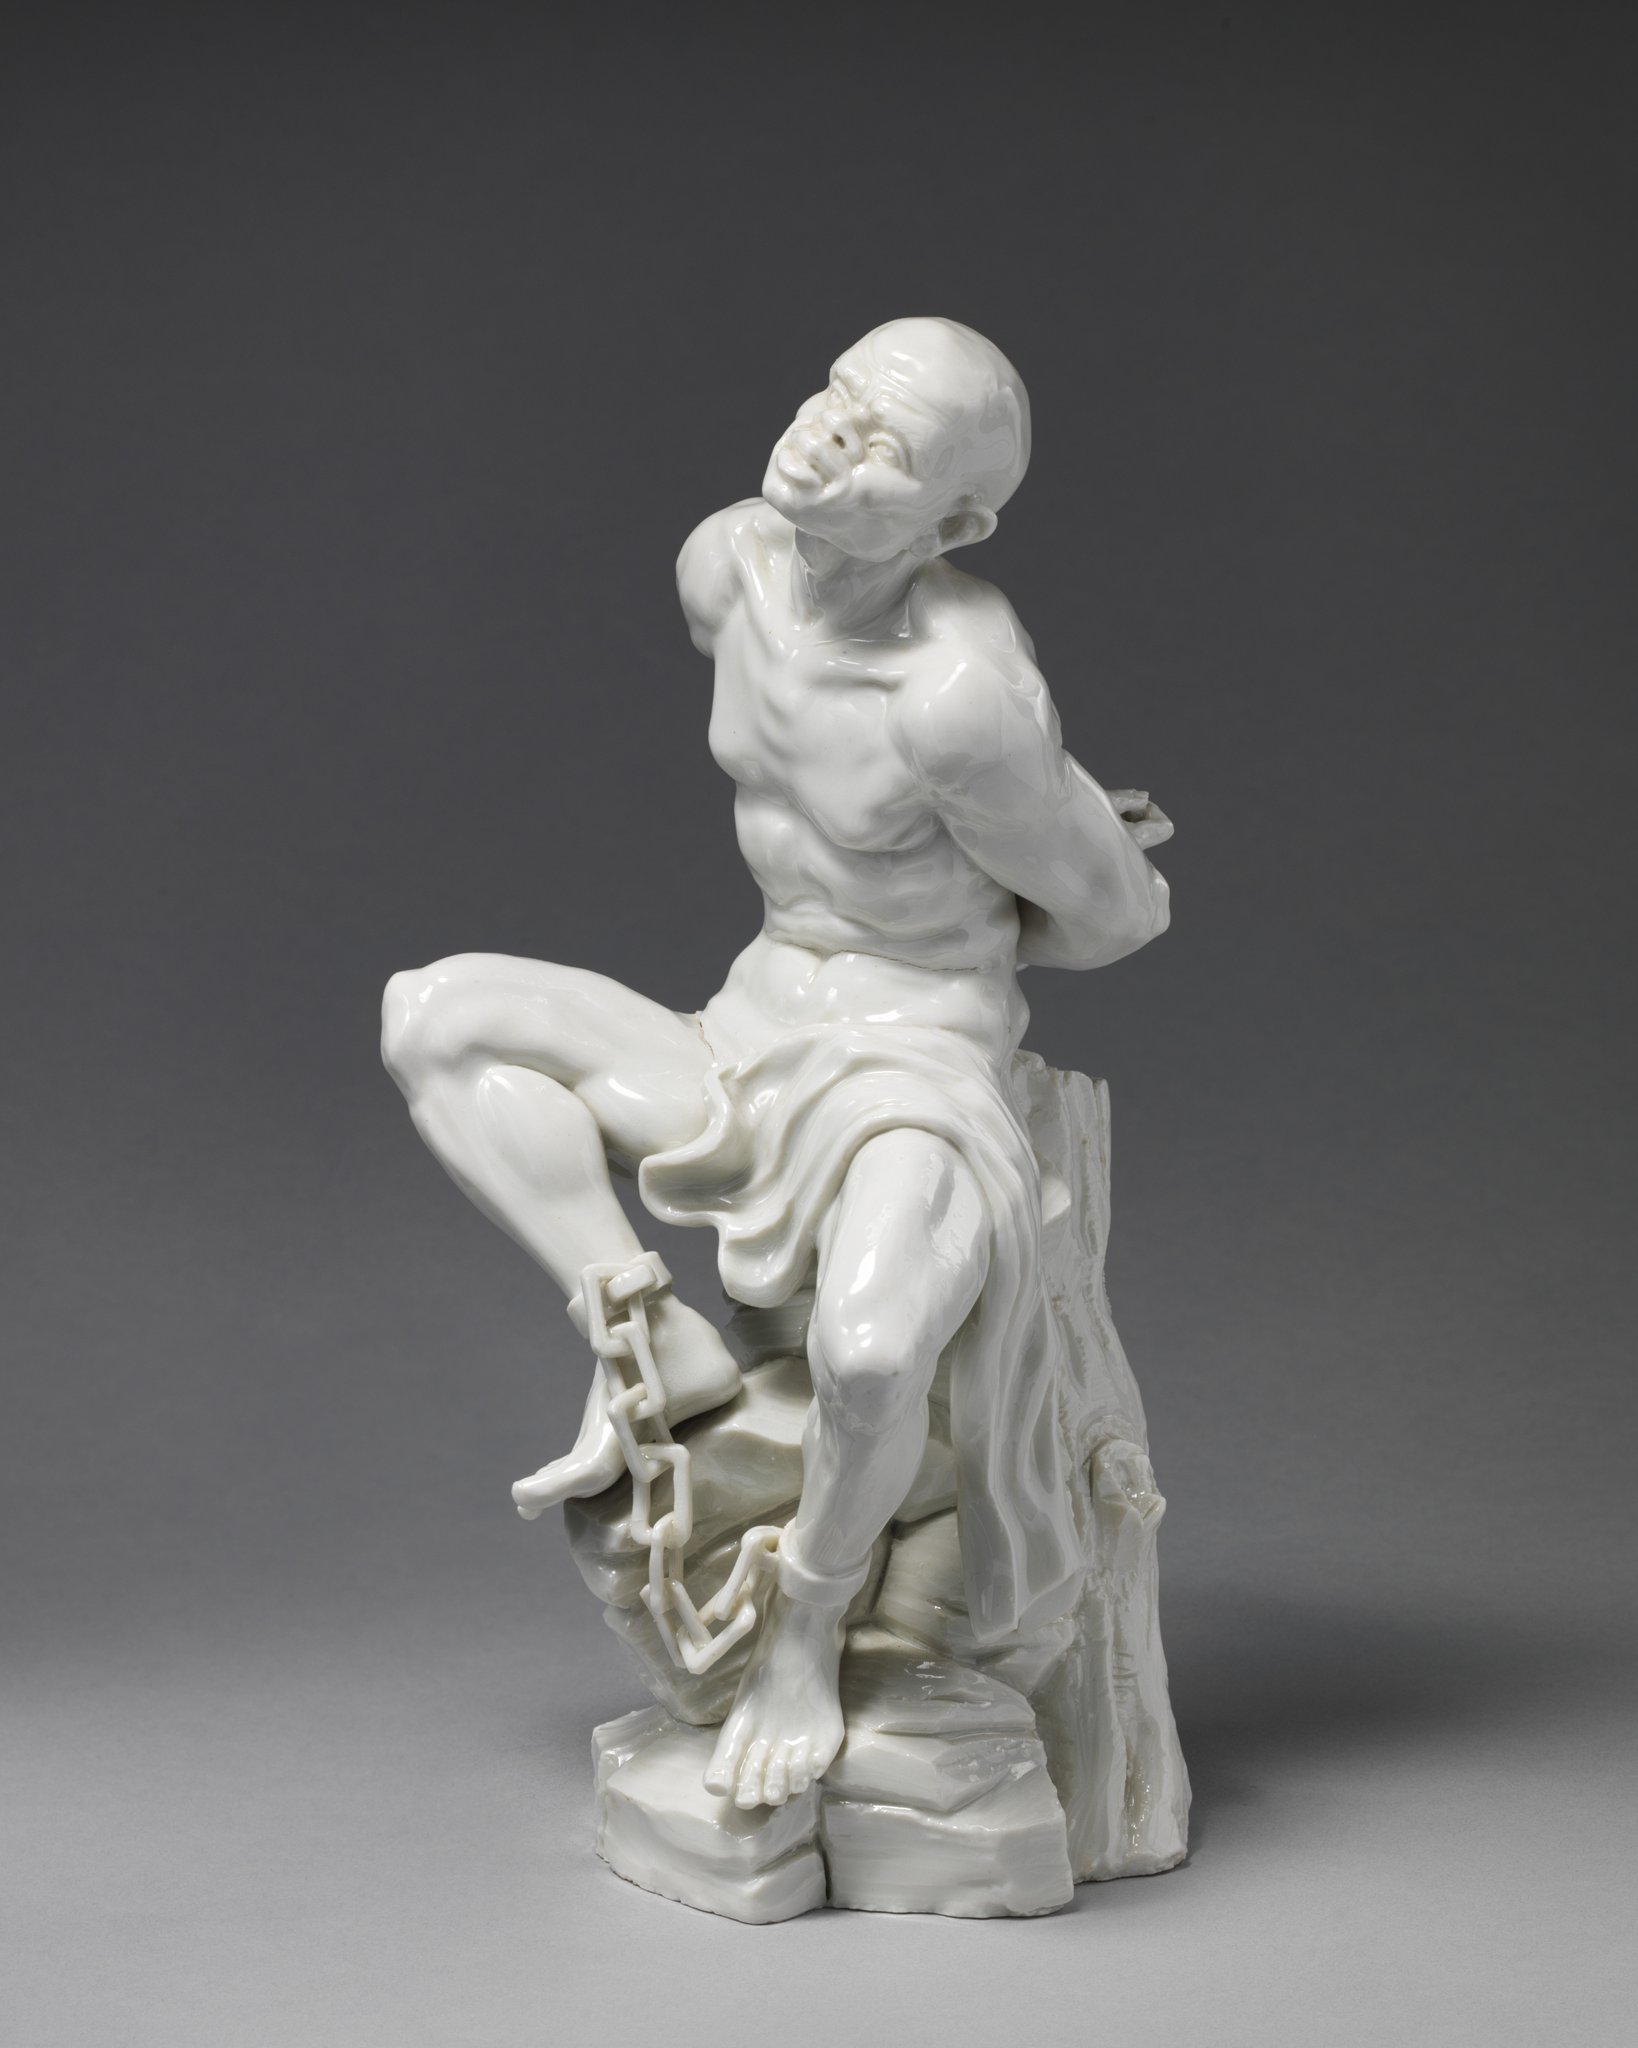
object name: figure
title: Figure of an Enslaved African Man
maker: giuseppe piamontini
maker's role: artist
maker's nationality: italian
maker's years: 1664-1742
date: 1767-1800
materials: hard paste porcelain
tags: men,slavery